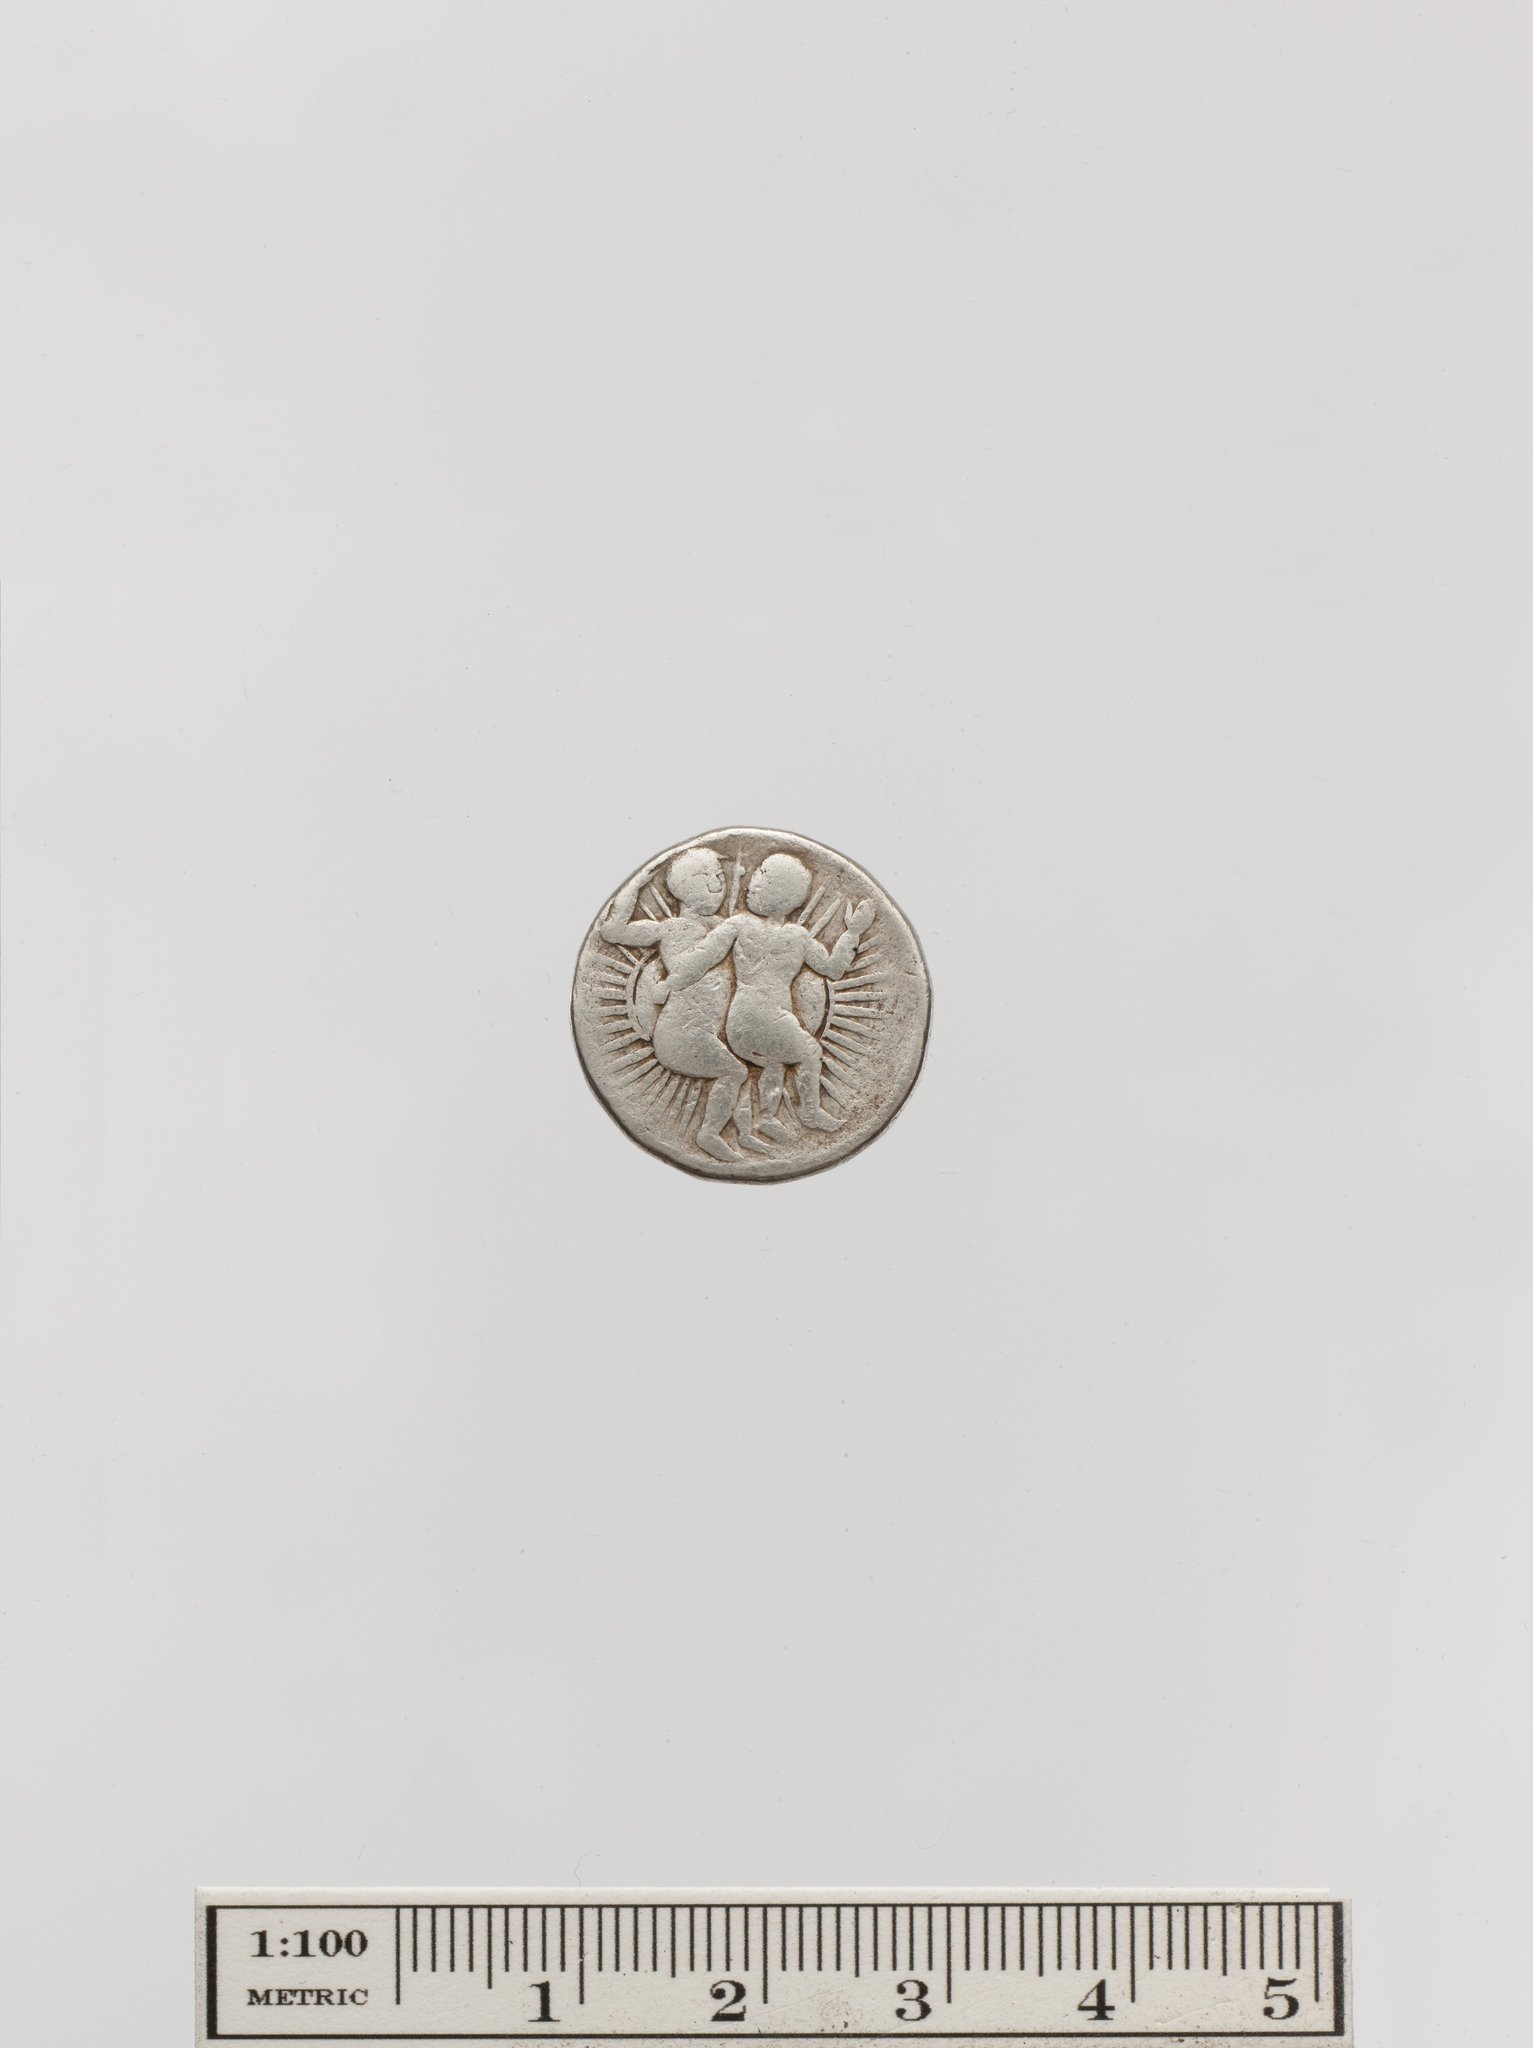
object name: coin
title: Coin with Gemini Zodiac Sign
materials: silver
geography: india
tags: zodiac